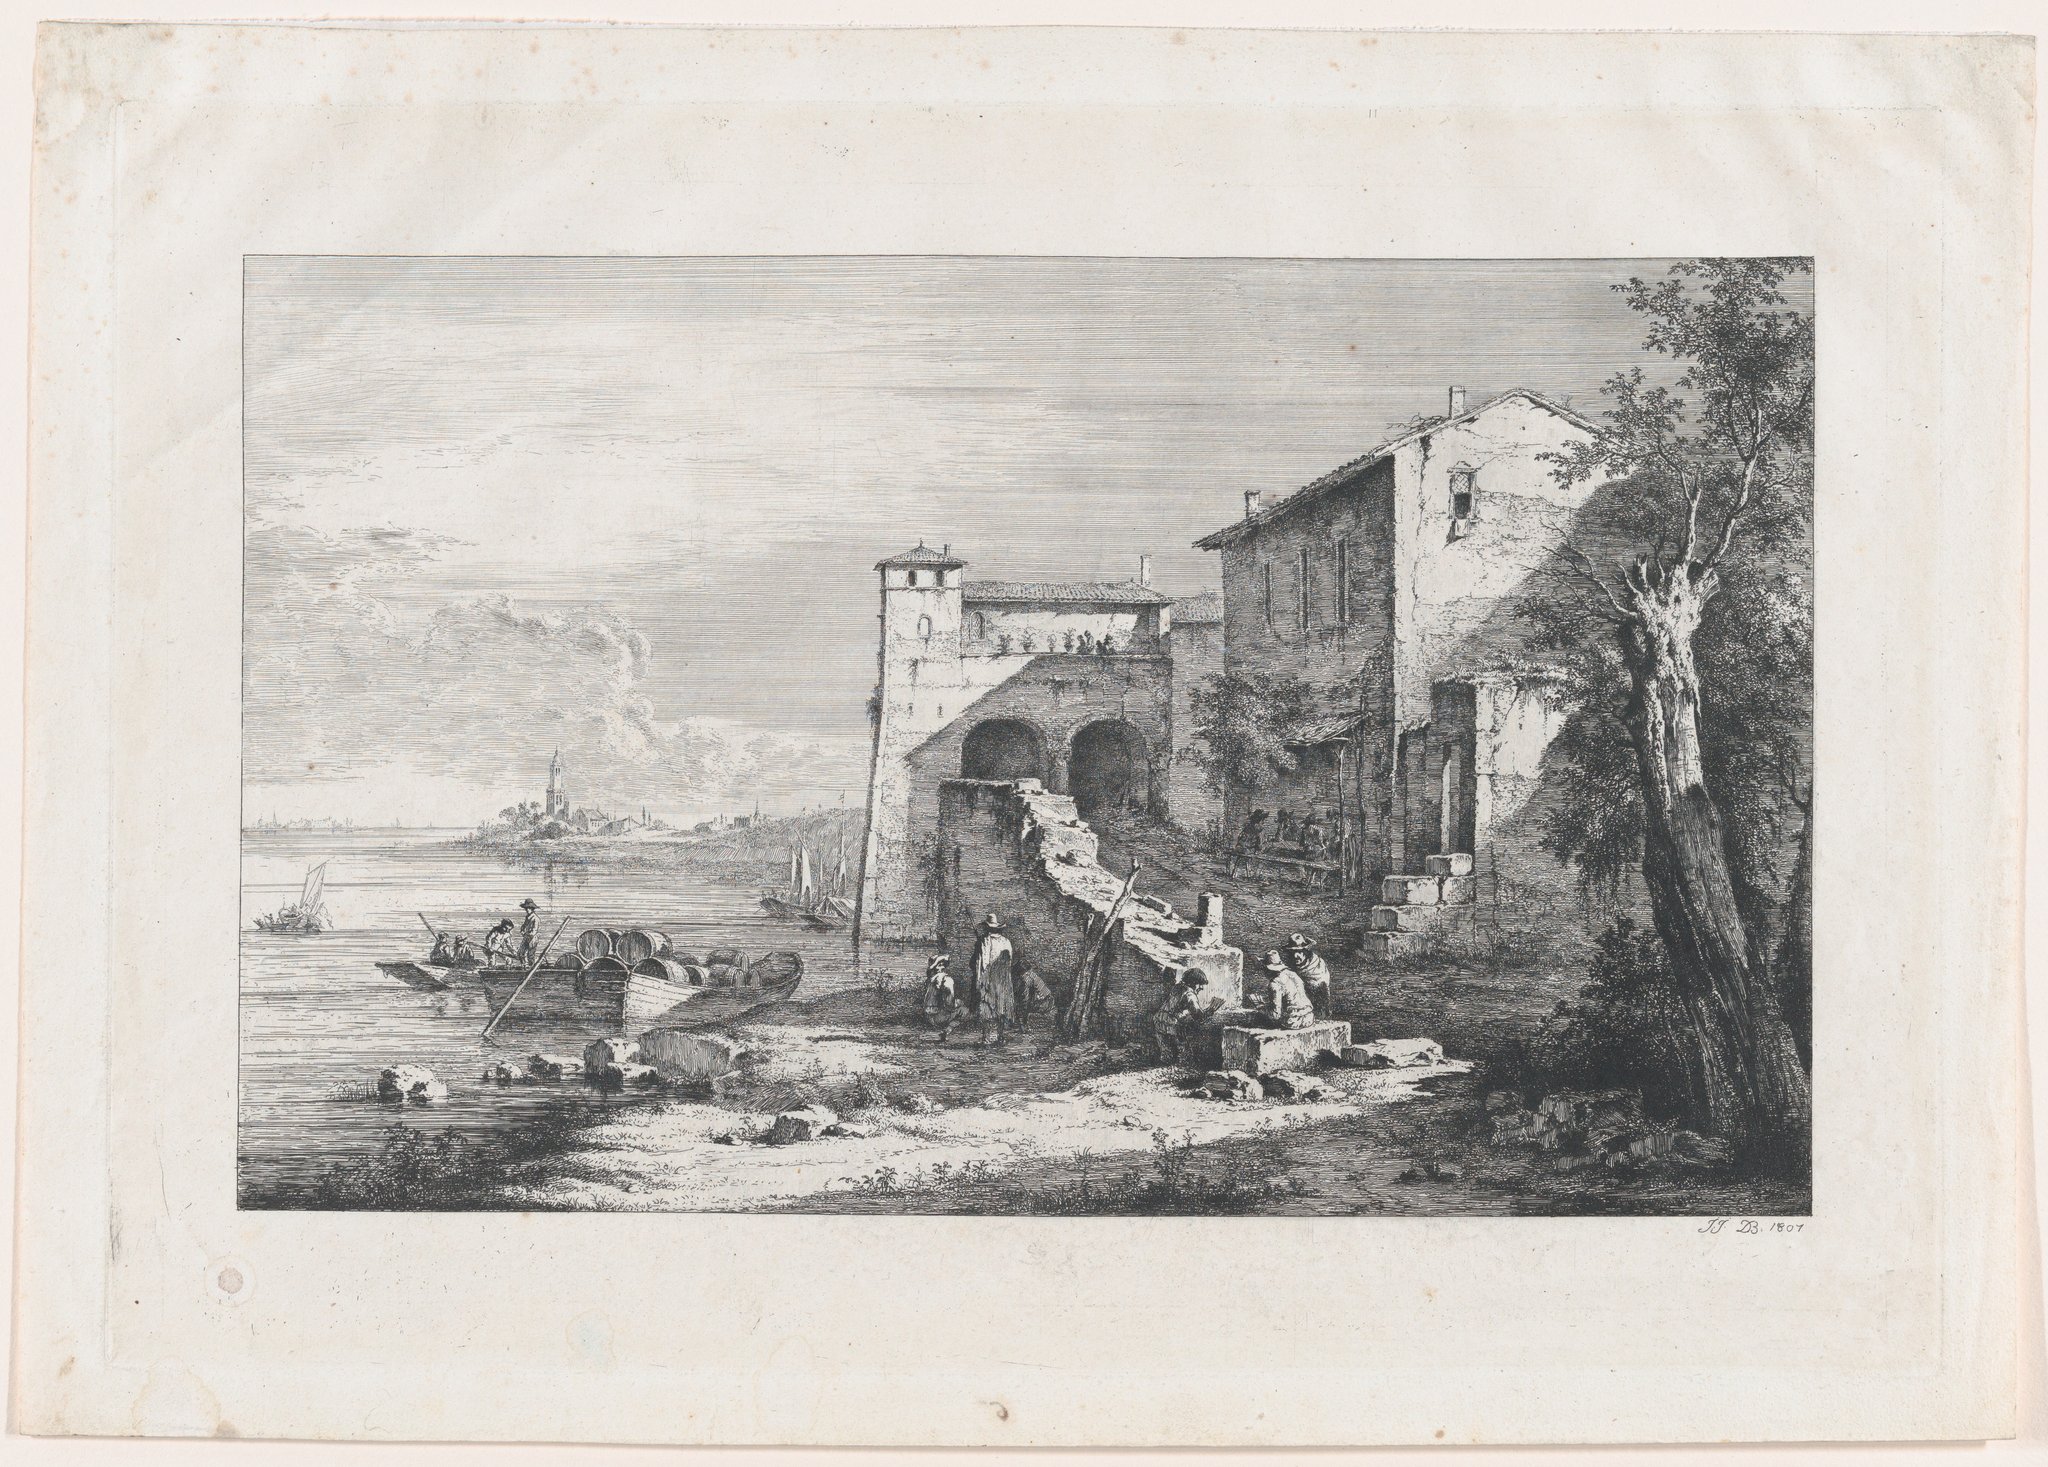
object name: print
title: View of Old Customs House in Rome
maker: jean jacques de boissieu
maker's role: artist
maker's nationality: french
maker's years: 1736-1810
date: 1807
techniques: drypoint, etching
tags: buildings,men,boats,rome